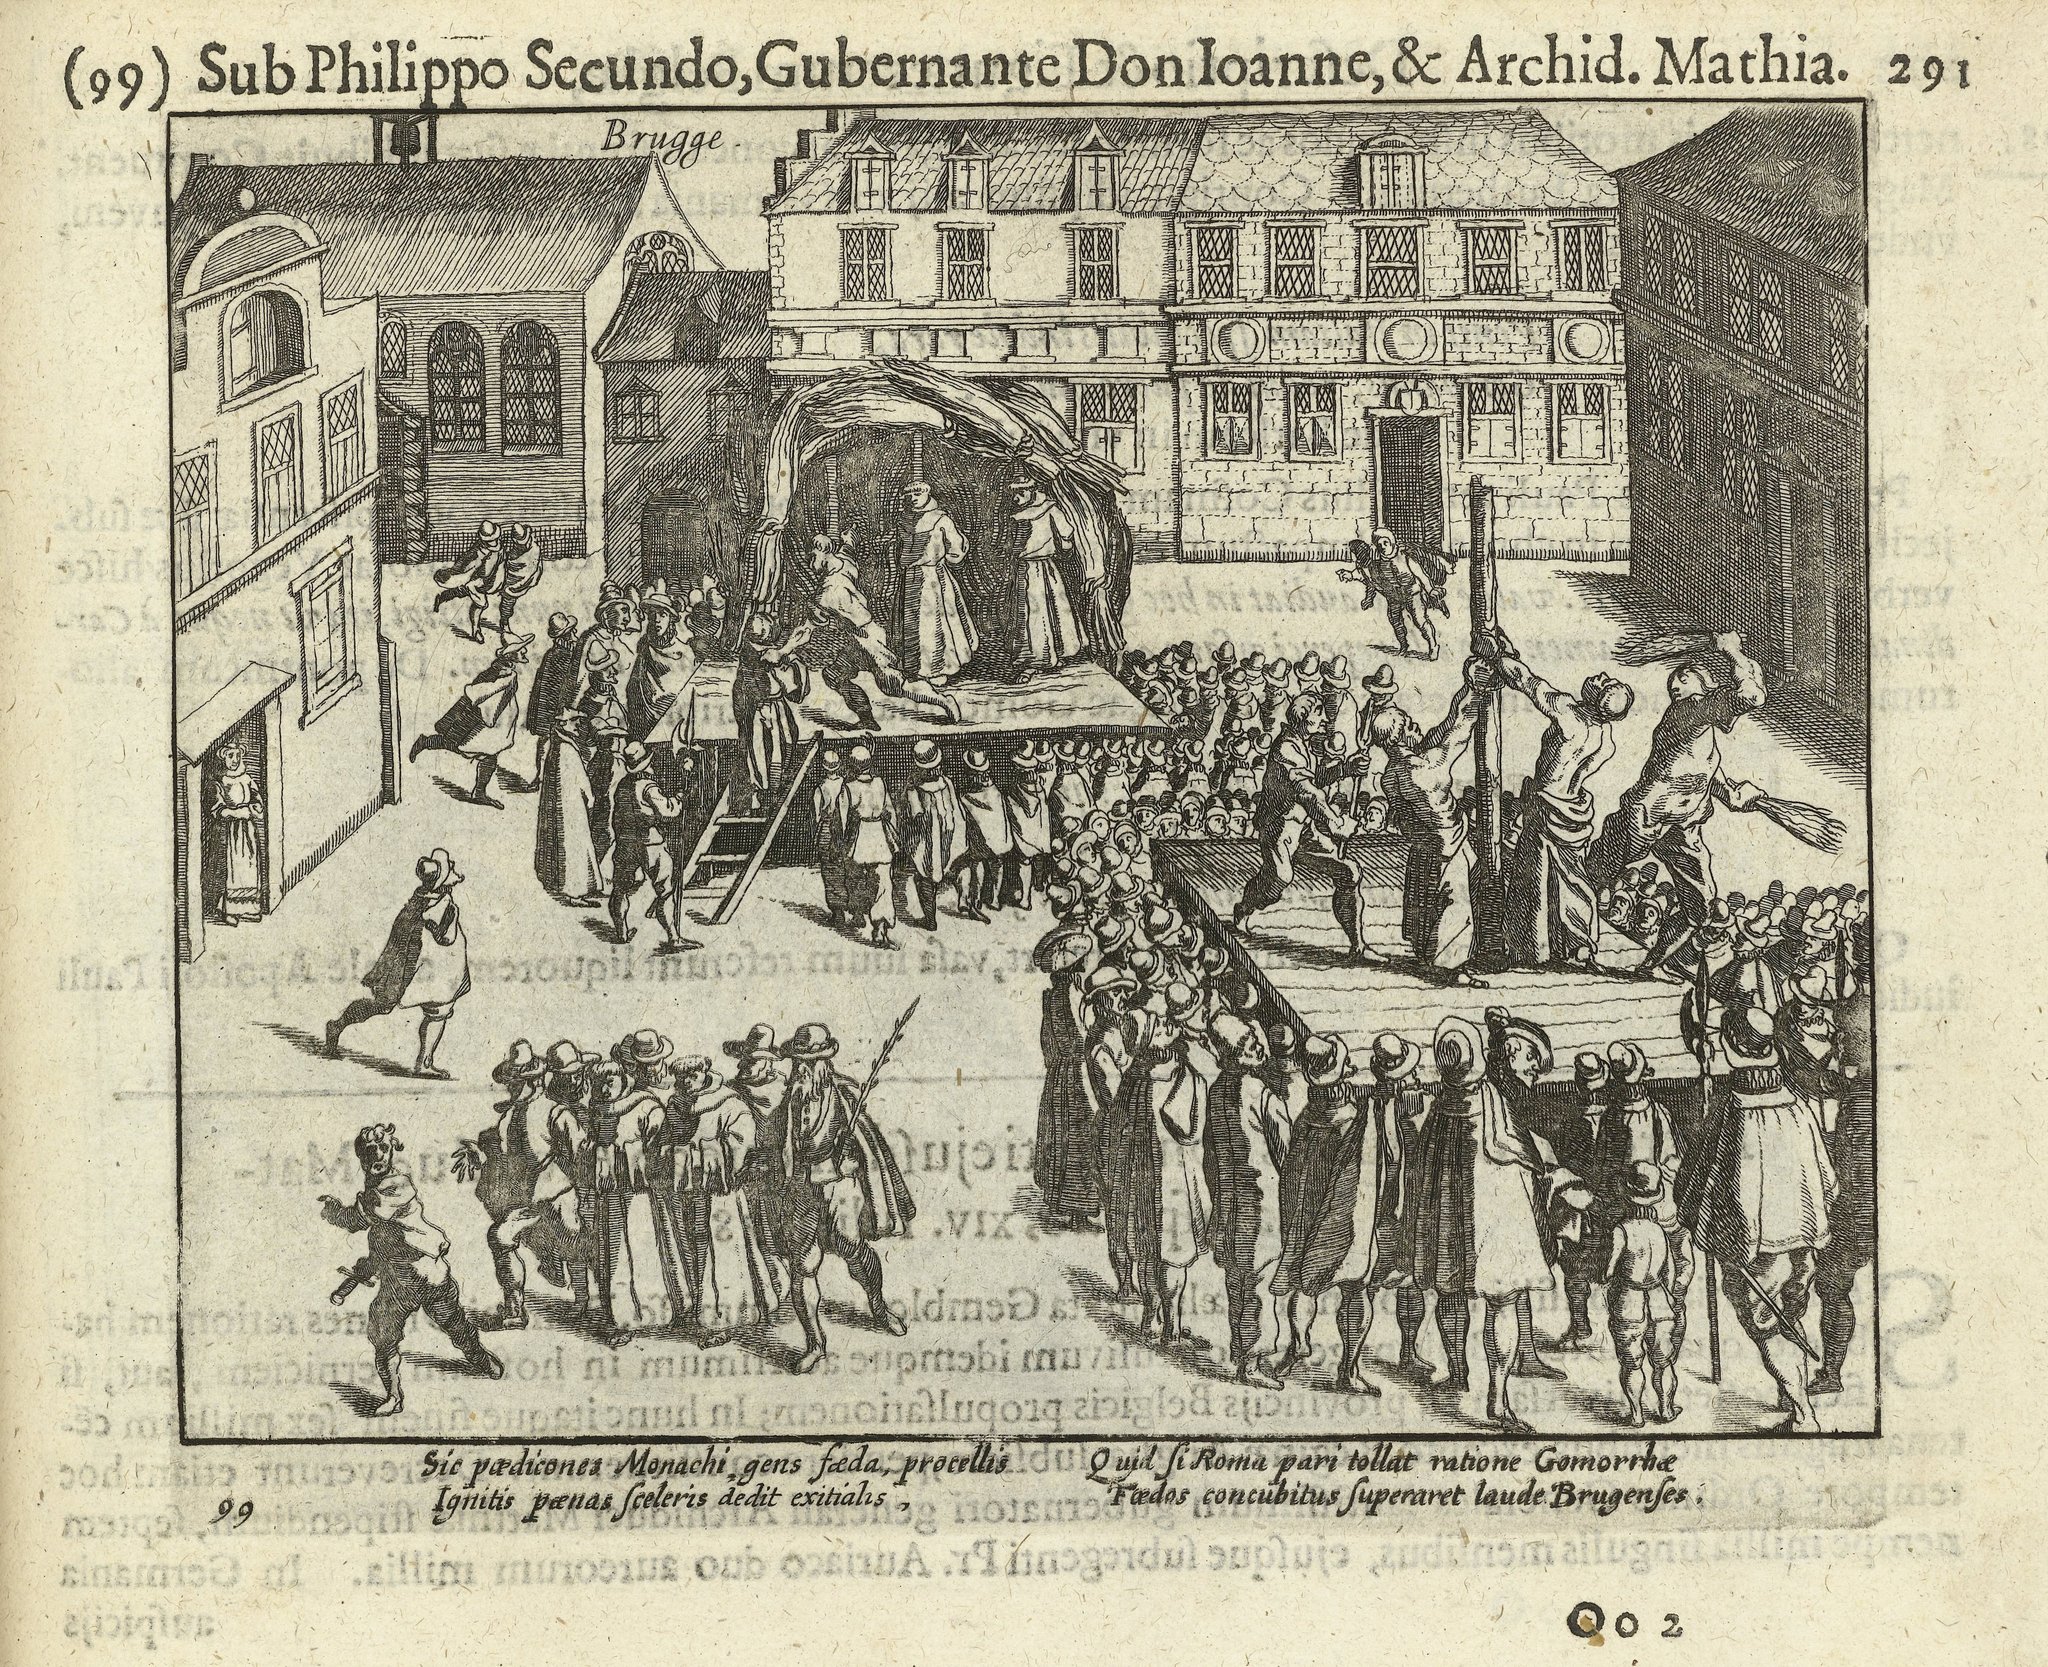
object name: history print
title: Brugse monniken op de brandstapel, 1578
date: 1613-1615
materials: paper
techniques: etching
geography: northern netherlands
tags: sodomy, sexual contact between men, violent death by burning at the stake; pyre, bruges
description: Geseling en terechtstelling van de franciscaner monniken te Brugge op beschuldiging van sodomie, 26 juli 1578. Rechts de geseling, links de monniken op de brandstapel. Met onderschrift van 4 regels in het Latijn. Genummerd: 99. Bedrukt op achterzijde met tekst in het Latijn.